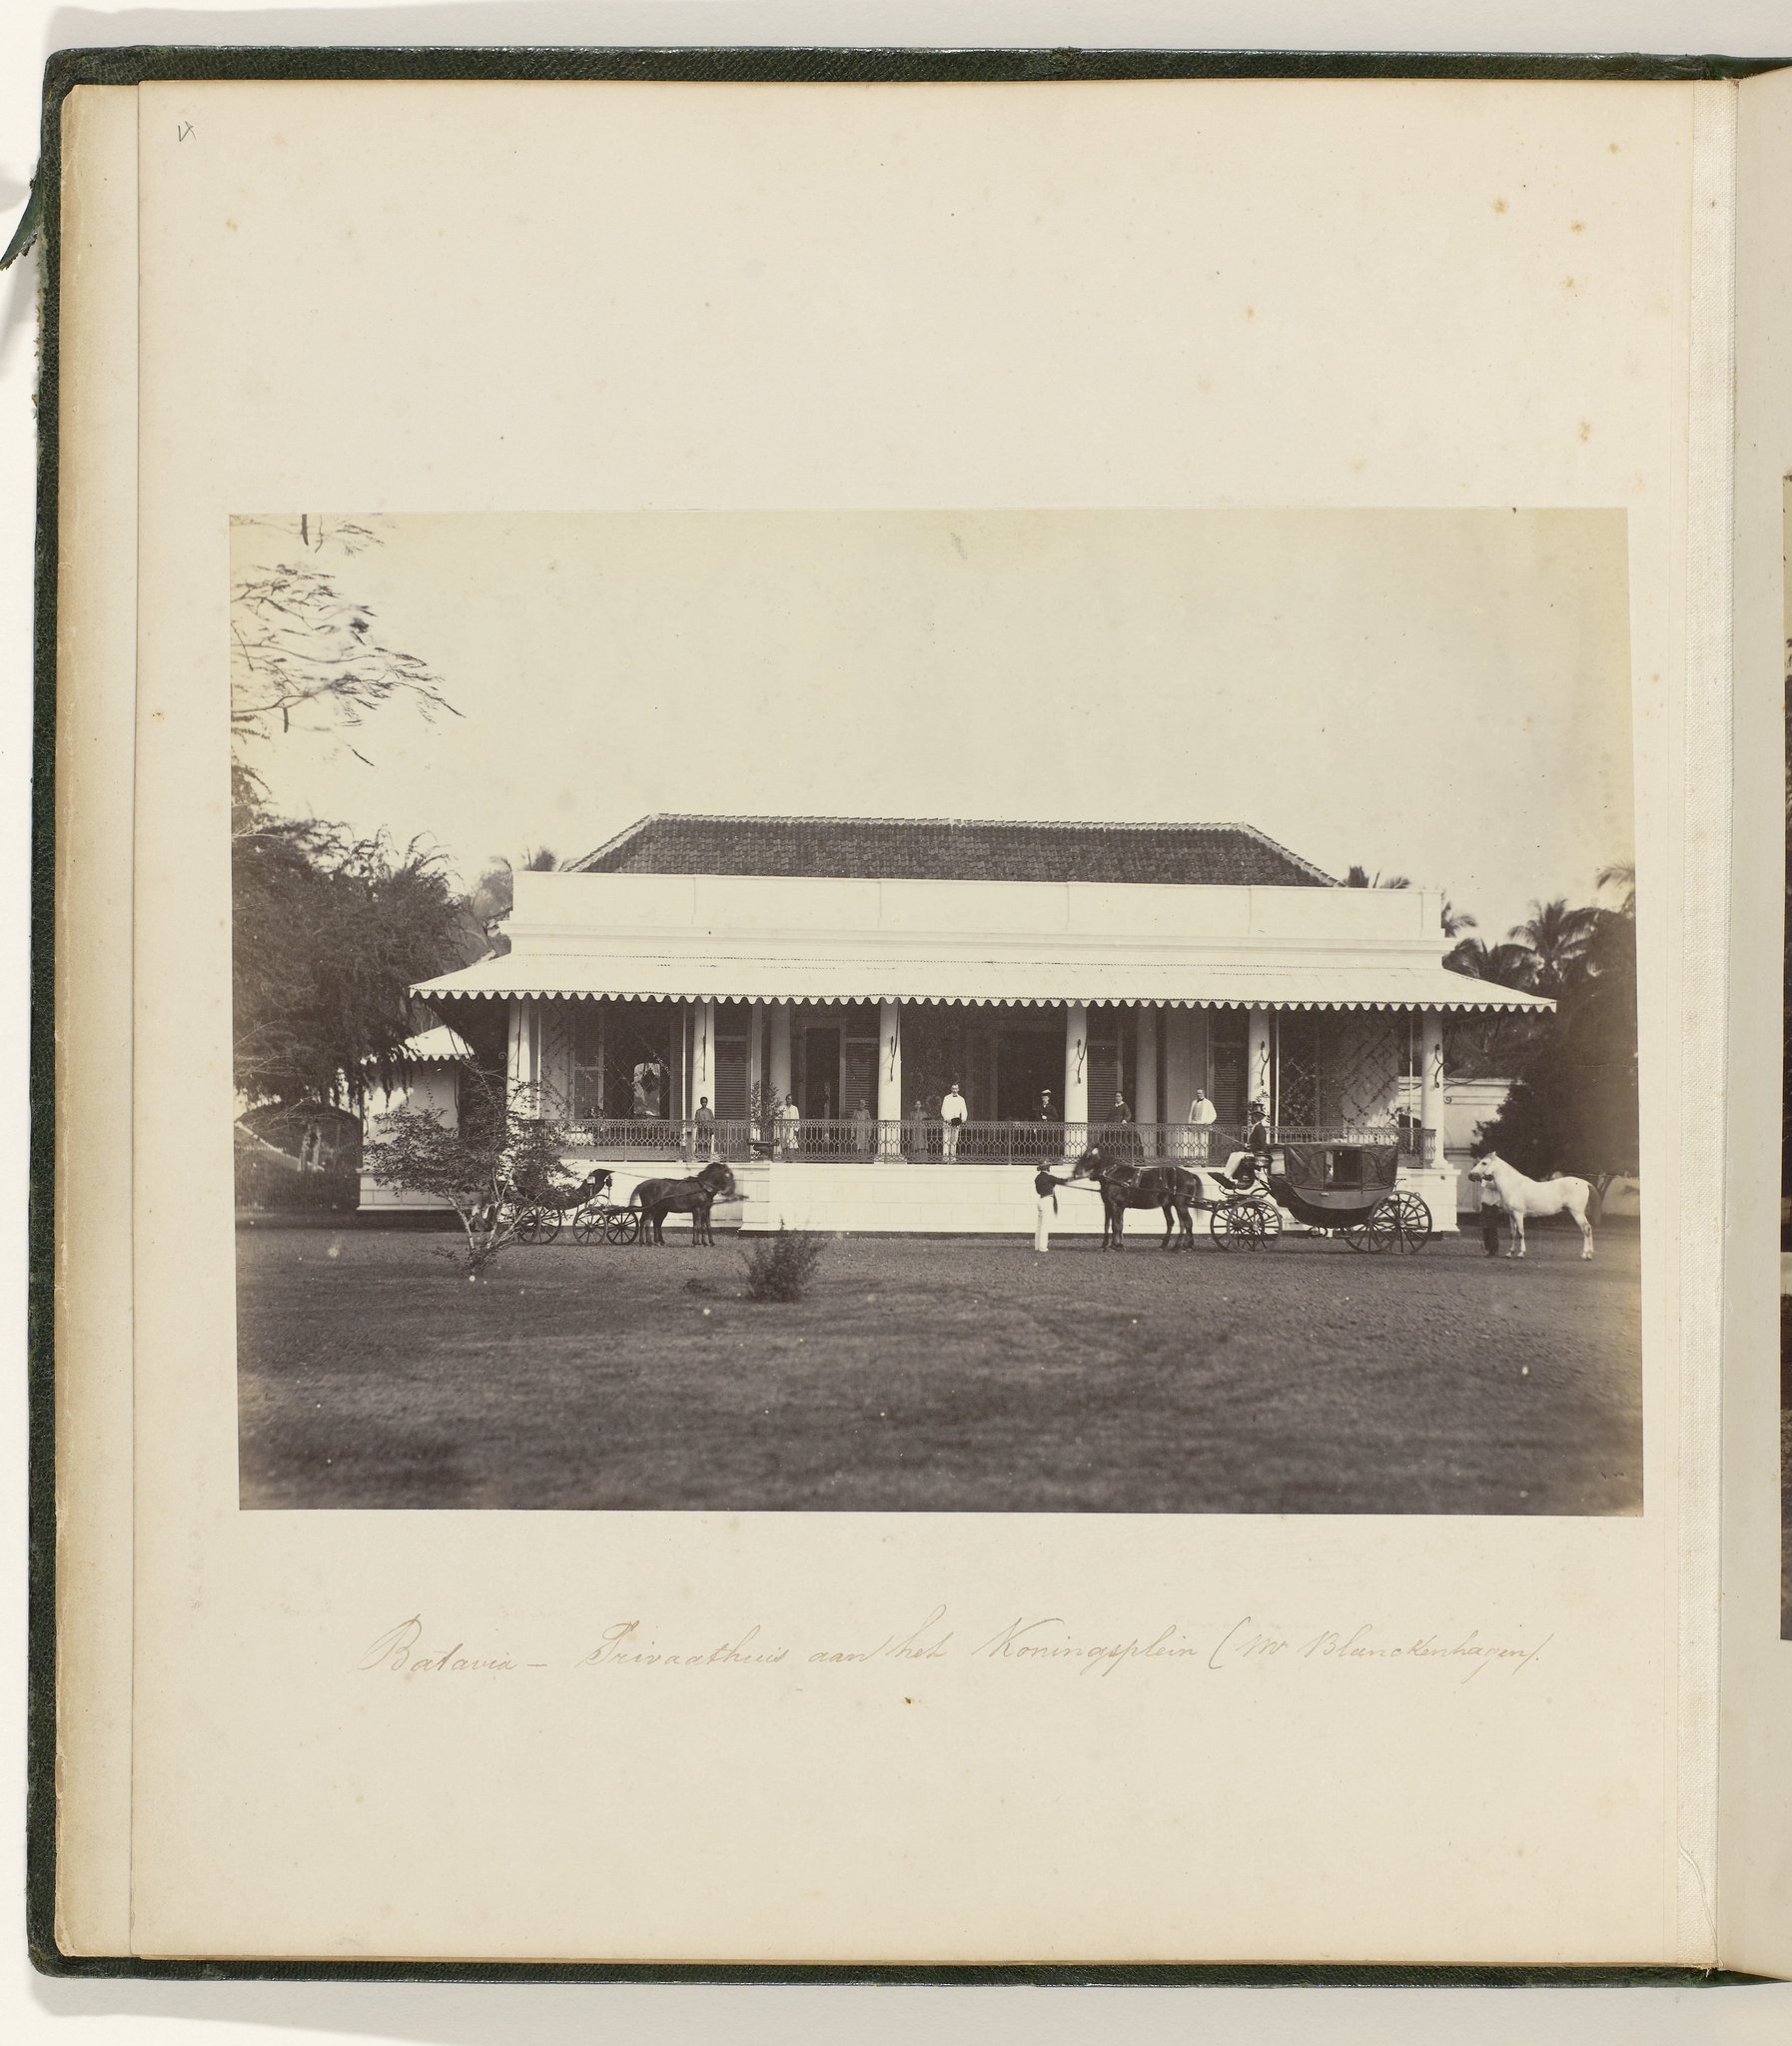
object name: photograph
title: Batavia - privaathuis aan het Koningsplein (mr Blanckenhagen)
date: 1863-1866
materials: photographic support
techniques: albumen print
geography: batavia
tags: detached house in city, batavia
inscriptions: inscription: ‘Batavia - privaathuis aan het Koningsplein (mr Blanckenhagen)’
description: Het woonhuis van Johannes Blanckenhagen aan het Koningsplein te Batavia. De bewoners poseren op de veranda, voor het huis twee rijtuigen en een wit paard. Onderdeel van het tweede groene fotoalbum met foto's van Java, uit het bezit van apotheker Specht-Grijp, die in 1865 vanuit Batavia naar Nederland terugkeerde.